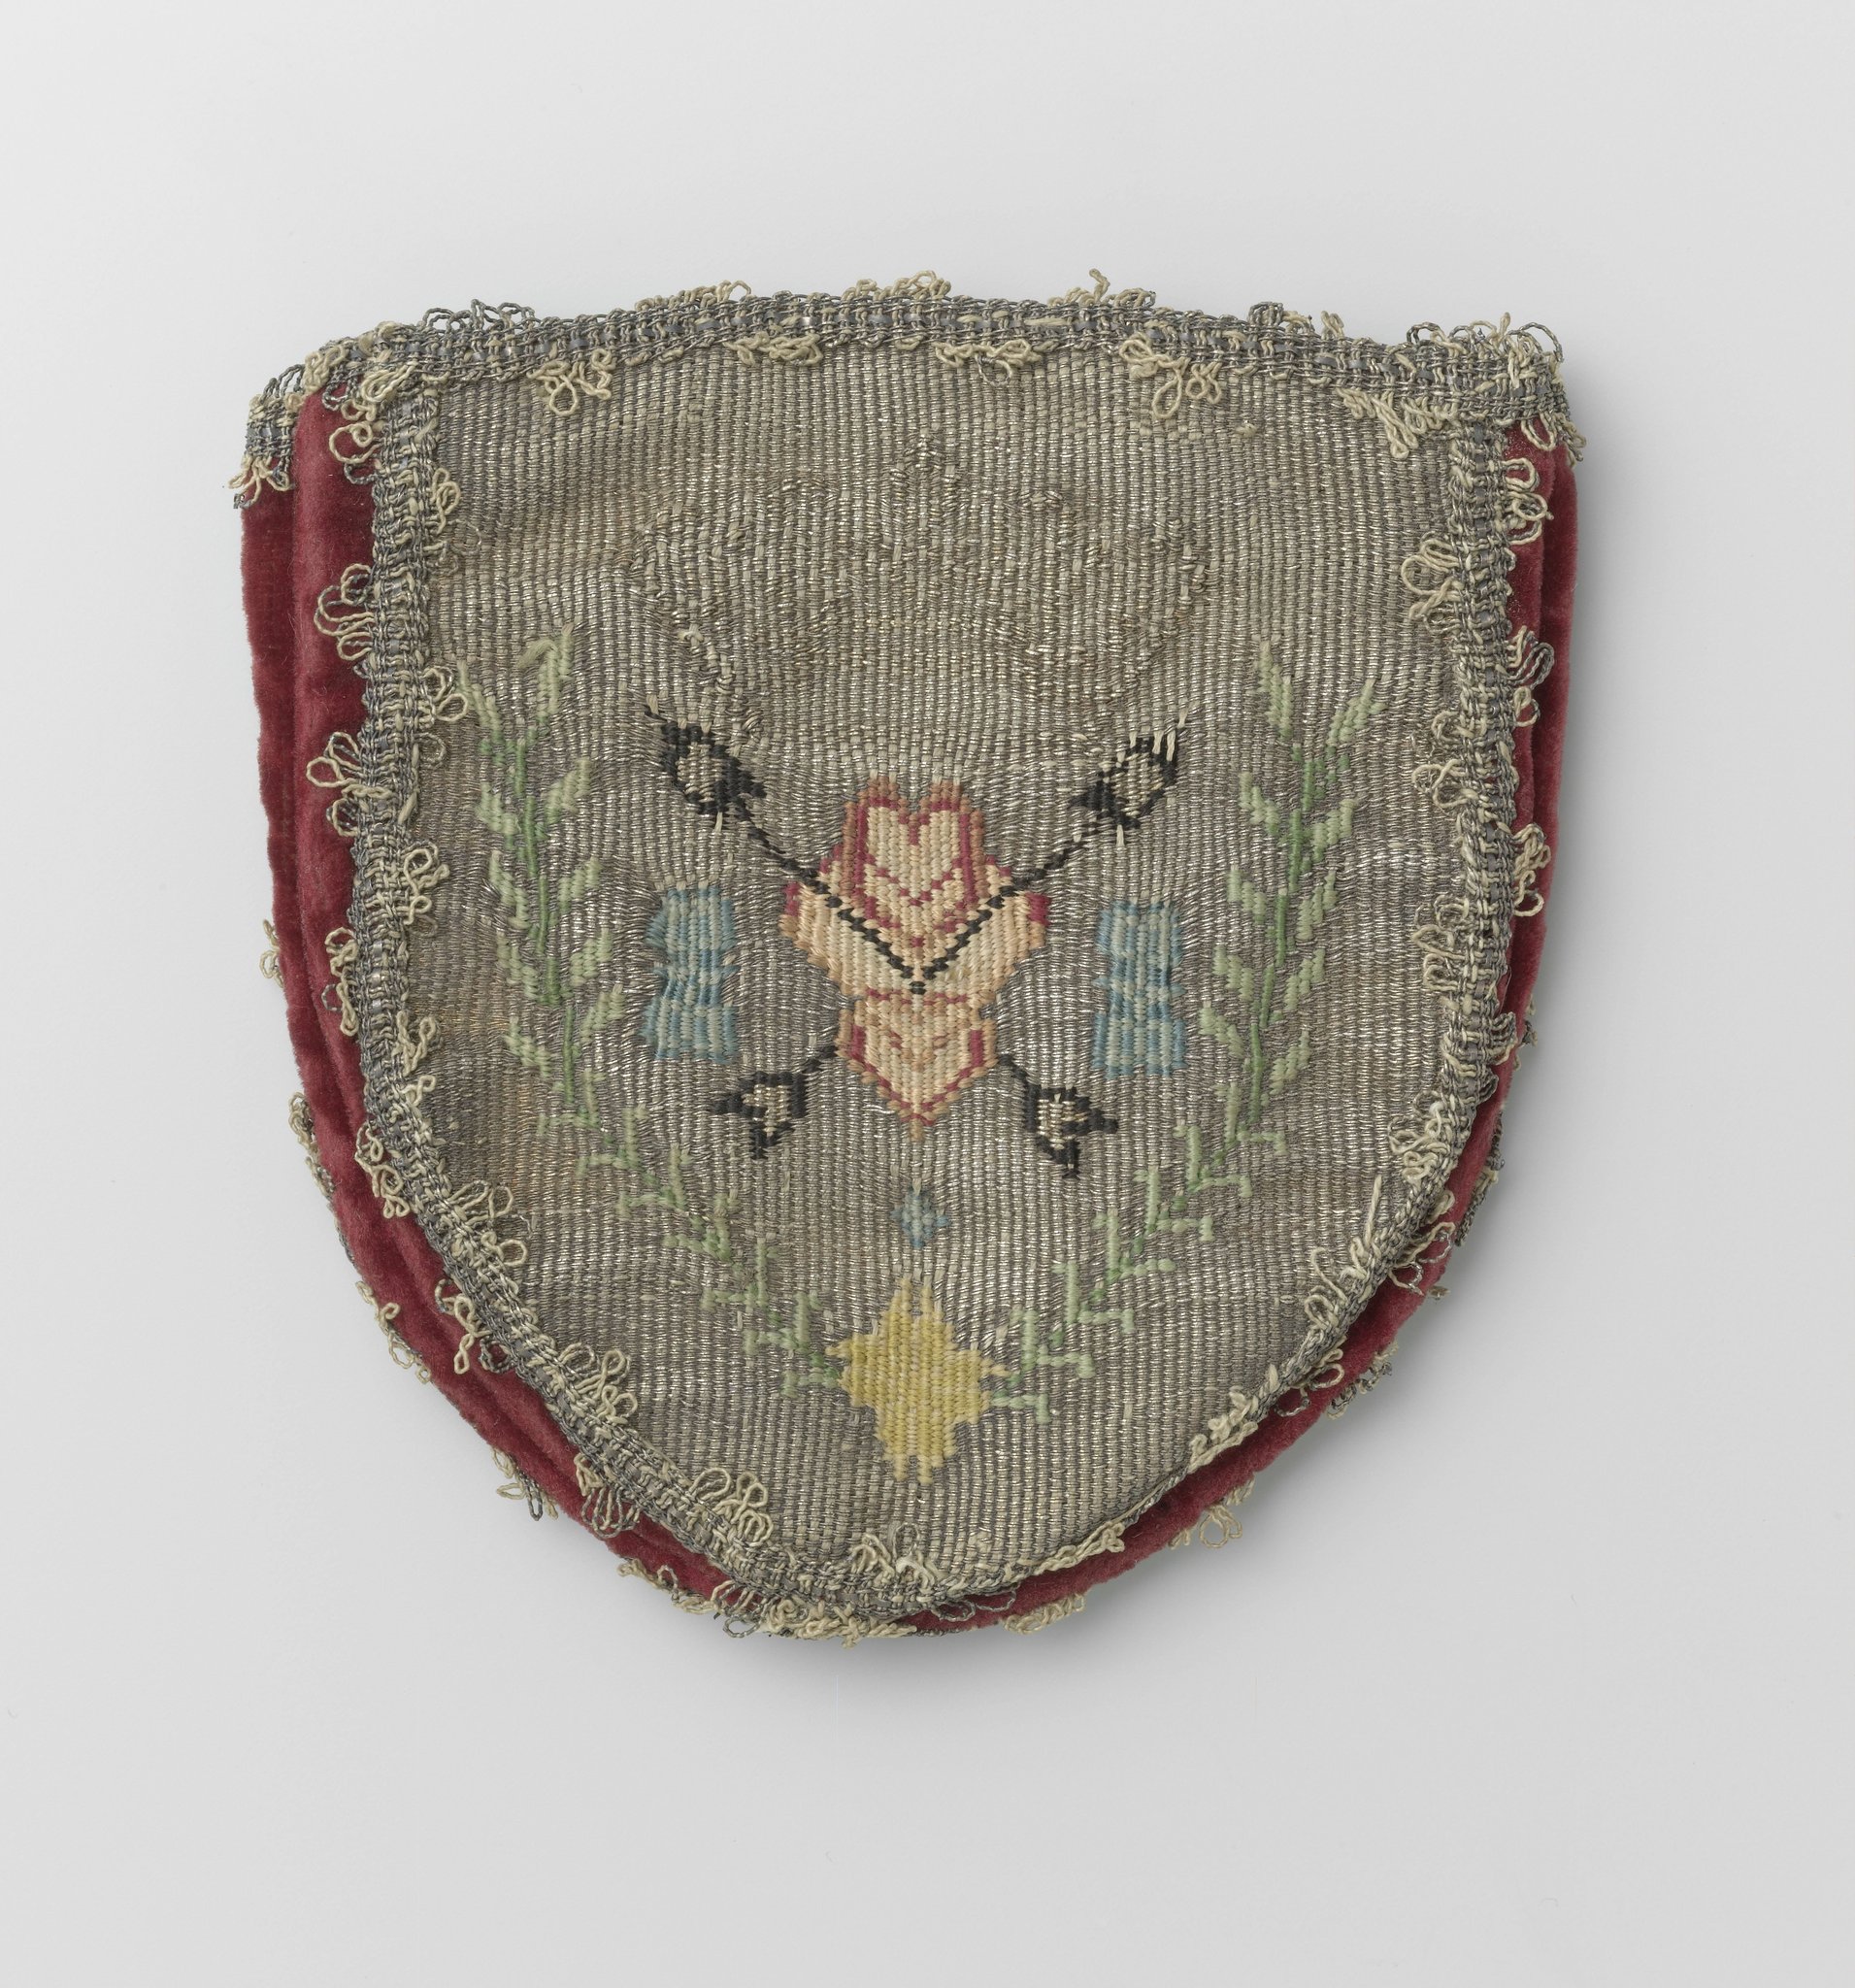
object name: beurs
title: Beursje in een schildvormigmodel van rood fluweel en zilverbrokaat, waarop aan twee kanten een driedubbel hart doorboord met pijlen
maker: Anonymous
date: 1700-1800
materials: cotton, silk, velvet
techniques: cutting, weave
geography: france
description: Beursje van zilverbrokaat. Twee schildvormige pattes zijn verbonden soufflés van rood fluweel. Op een grond van zilver staat een driedubbel hart doorboord met pijlen, in beige (verkleurd rose), rood en zwart. Hierboven een gouden kroon en langs de boog twee lauriertakken. Een zilverpassement bedekt de naden, voering van rose tafzijde, geen sluiting.